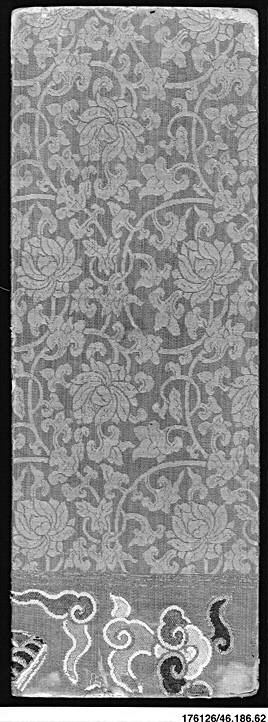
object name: sutra cover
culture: chinese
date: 1501-1600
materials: gold, paper, silk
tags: flowers